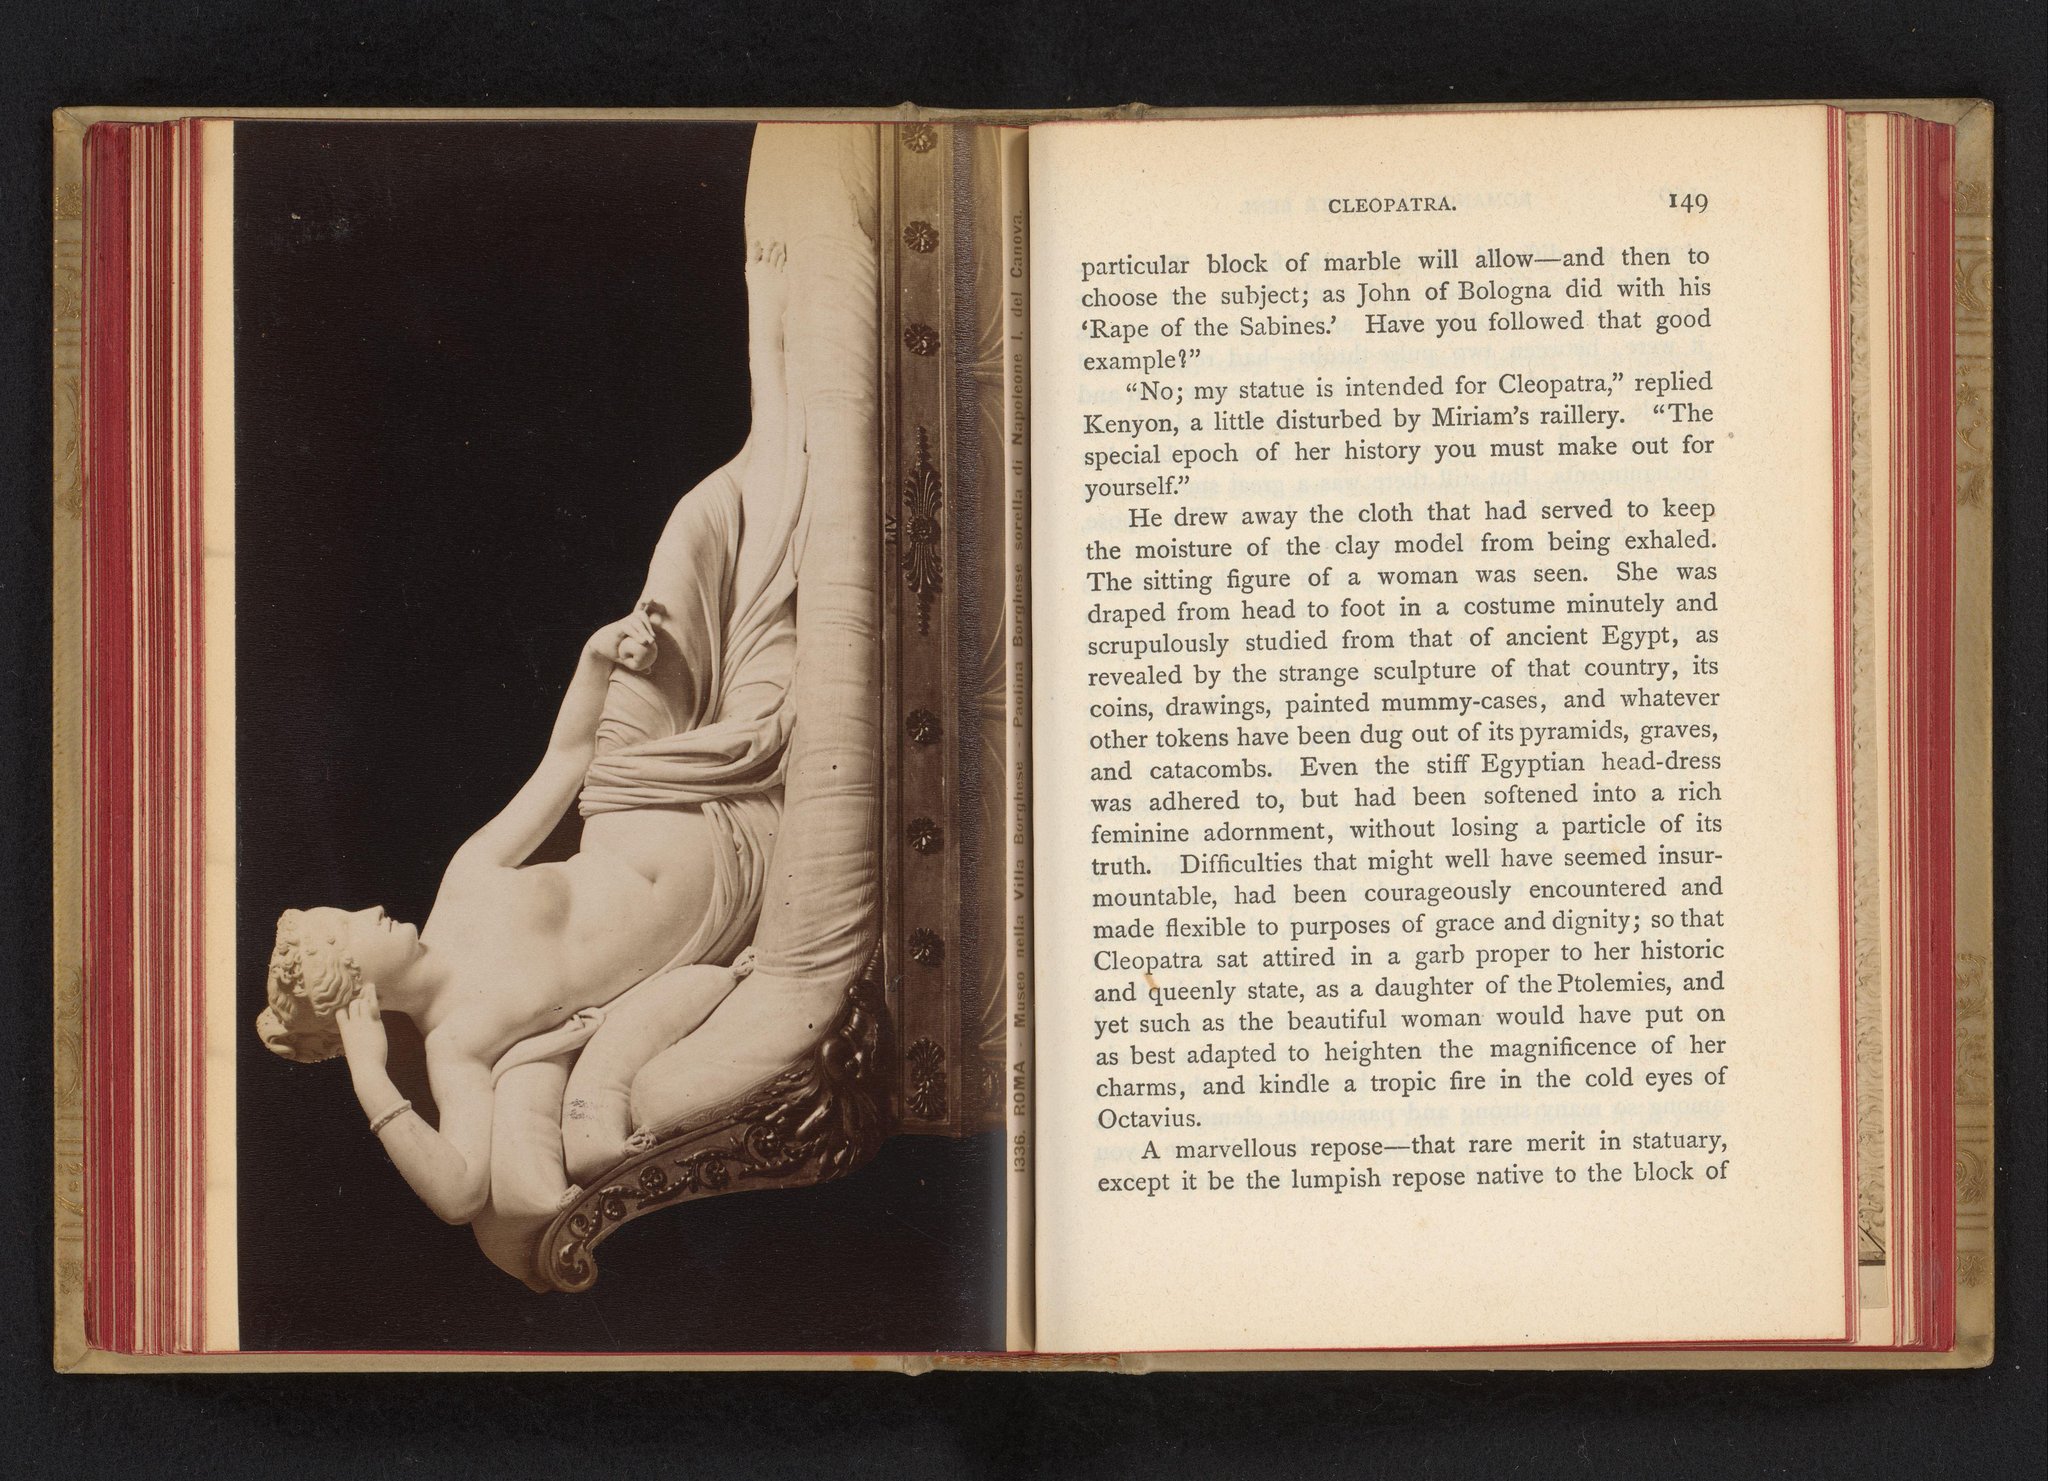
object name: page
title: Pauline Bonaparte als Venus Victrix door Antonio Canova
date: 1855-1860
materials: paper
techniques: albumen print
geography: villa borghese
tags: sculpture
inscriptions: number: ‘1336.’